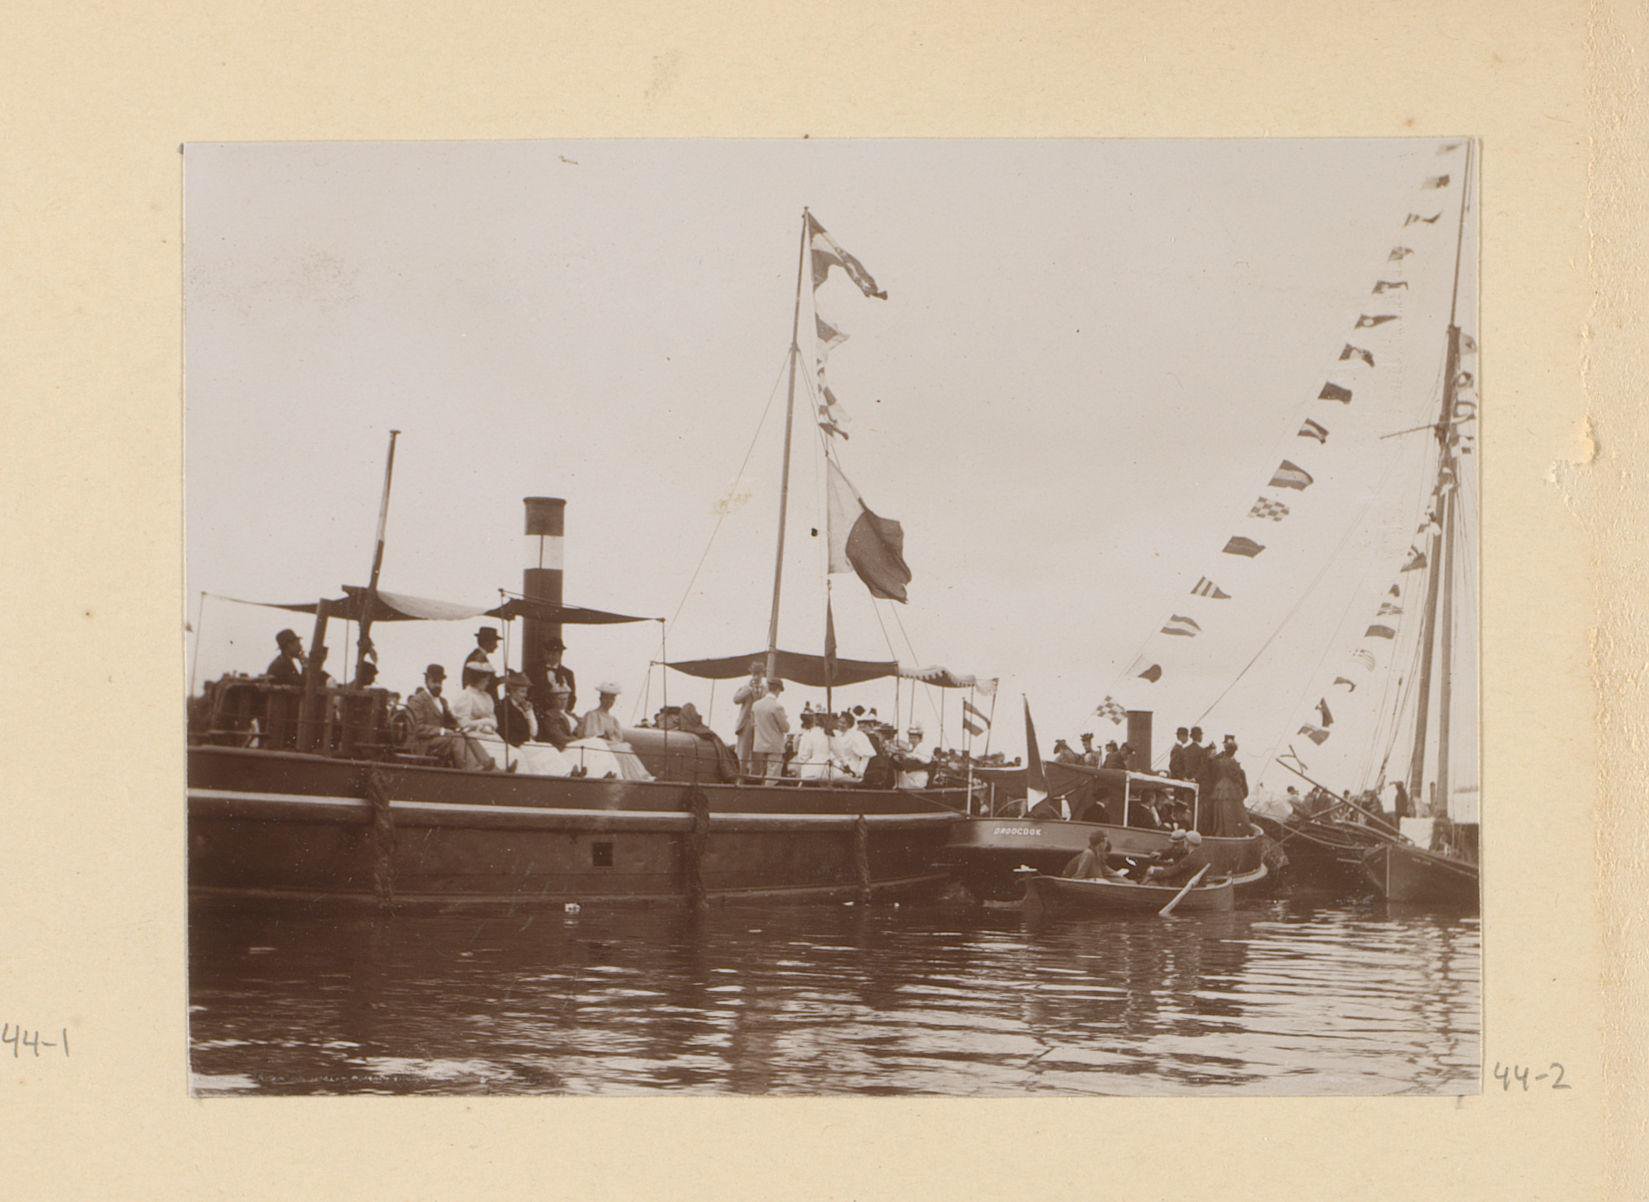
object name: photograph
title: Gezelschap op versierde boten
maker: hendrik herman van den berg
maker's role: amateurfotograaf, jurist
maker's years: 1875-1944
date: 1890-1894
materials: paper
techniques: collodion silver print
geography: amsterdam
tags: historical persons, ships (in general), amsterdam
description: Foto 2 op albumblad 44 uit album "Amsterdam 1890-1894".